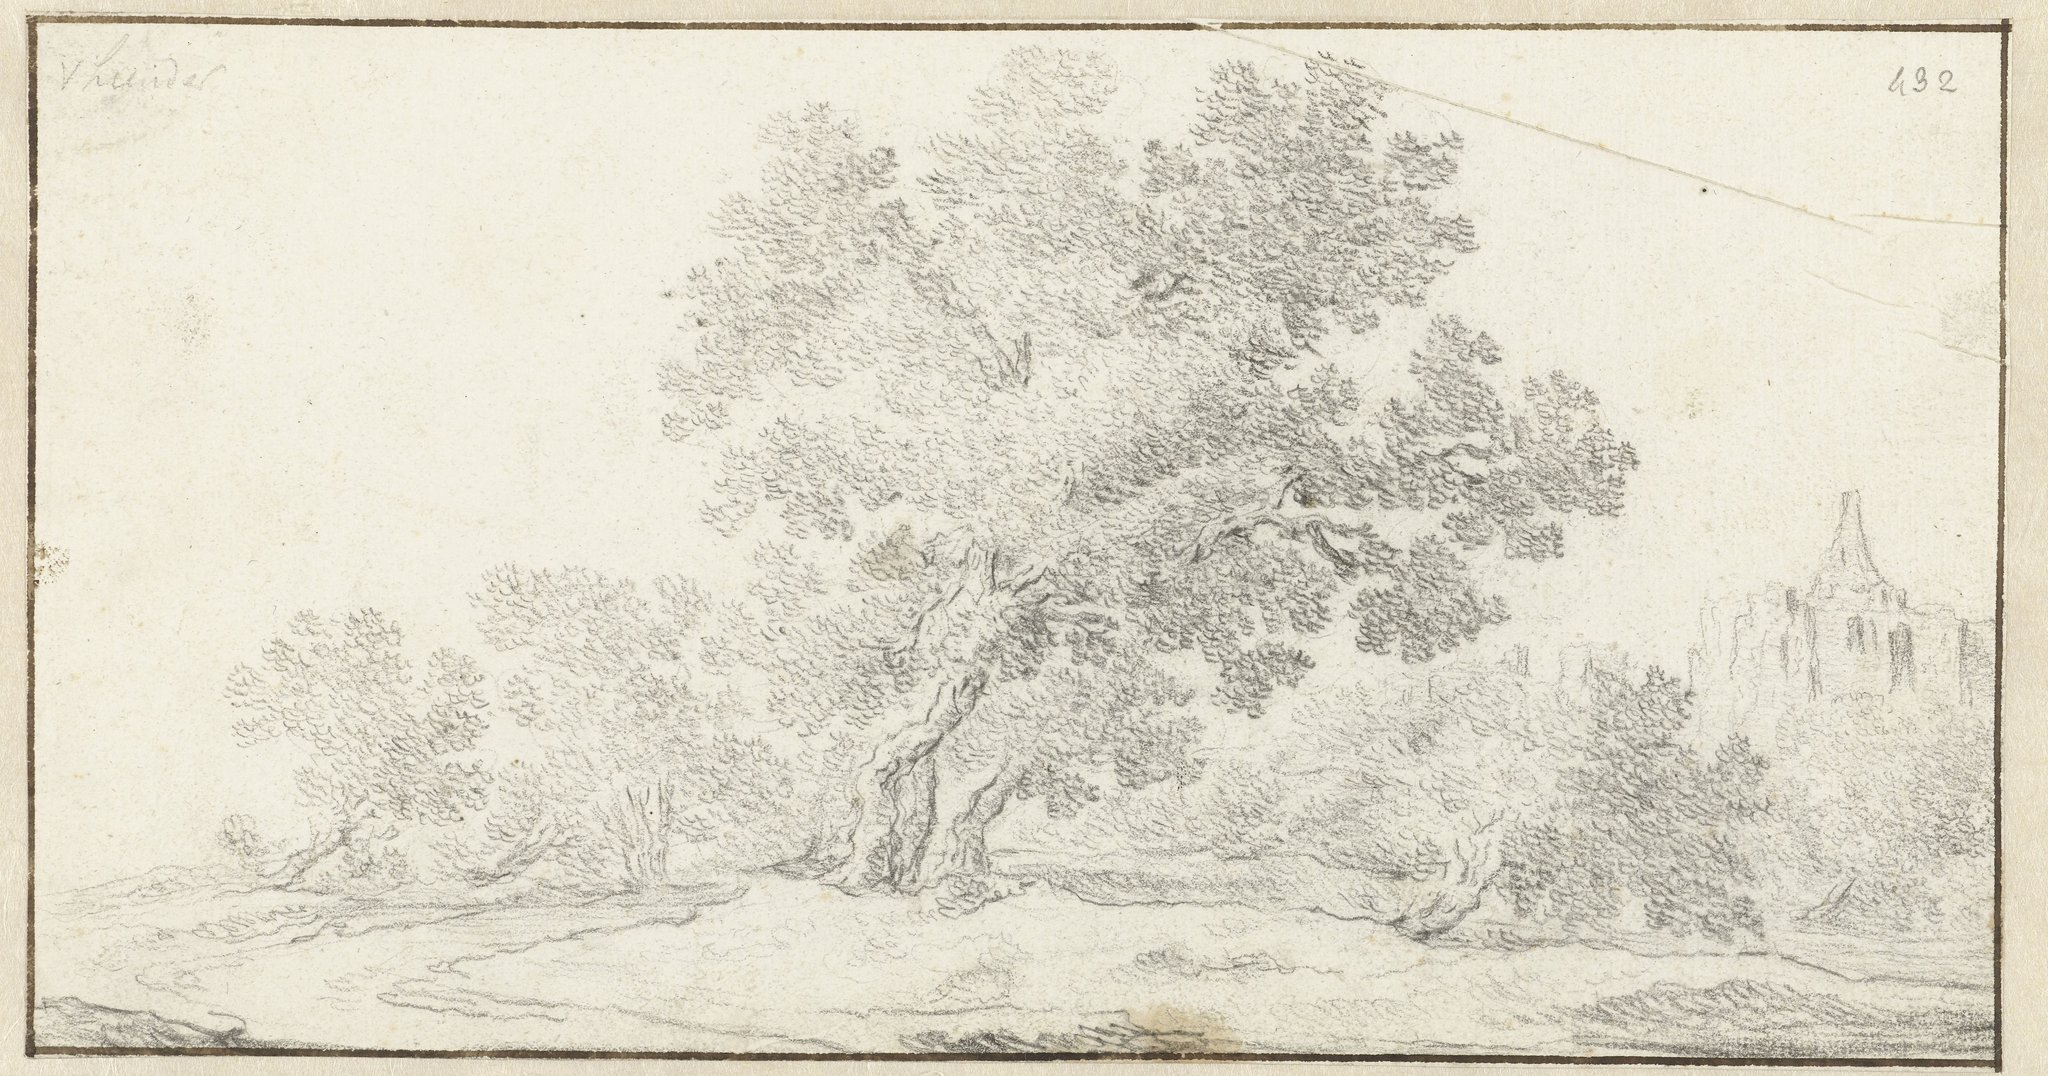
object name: drawing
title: Landschap met ruïne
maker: salomon van ruysdael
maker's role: draughtsman, painter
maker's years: 1600-1670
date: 1610-1670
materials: chalk, paper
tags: landscape with ruins